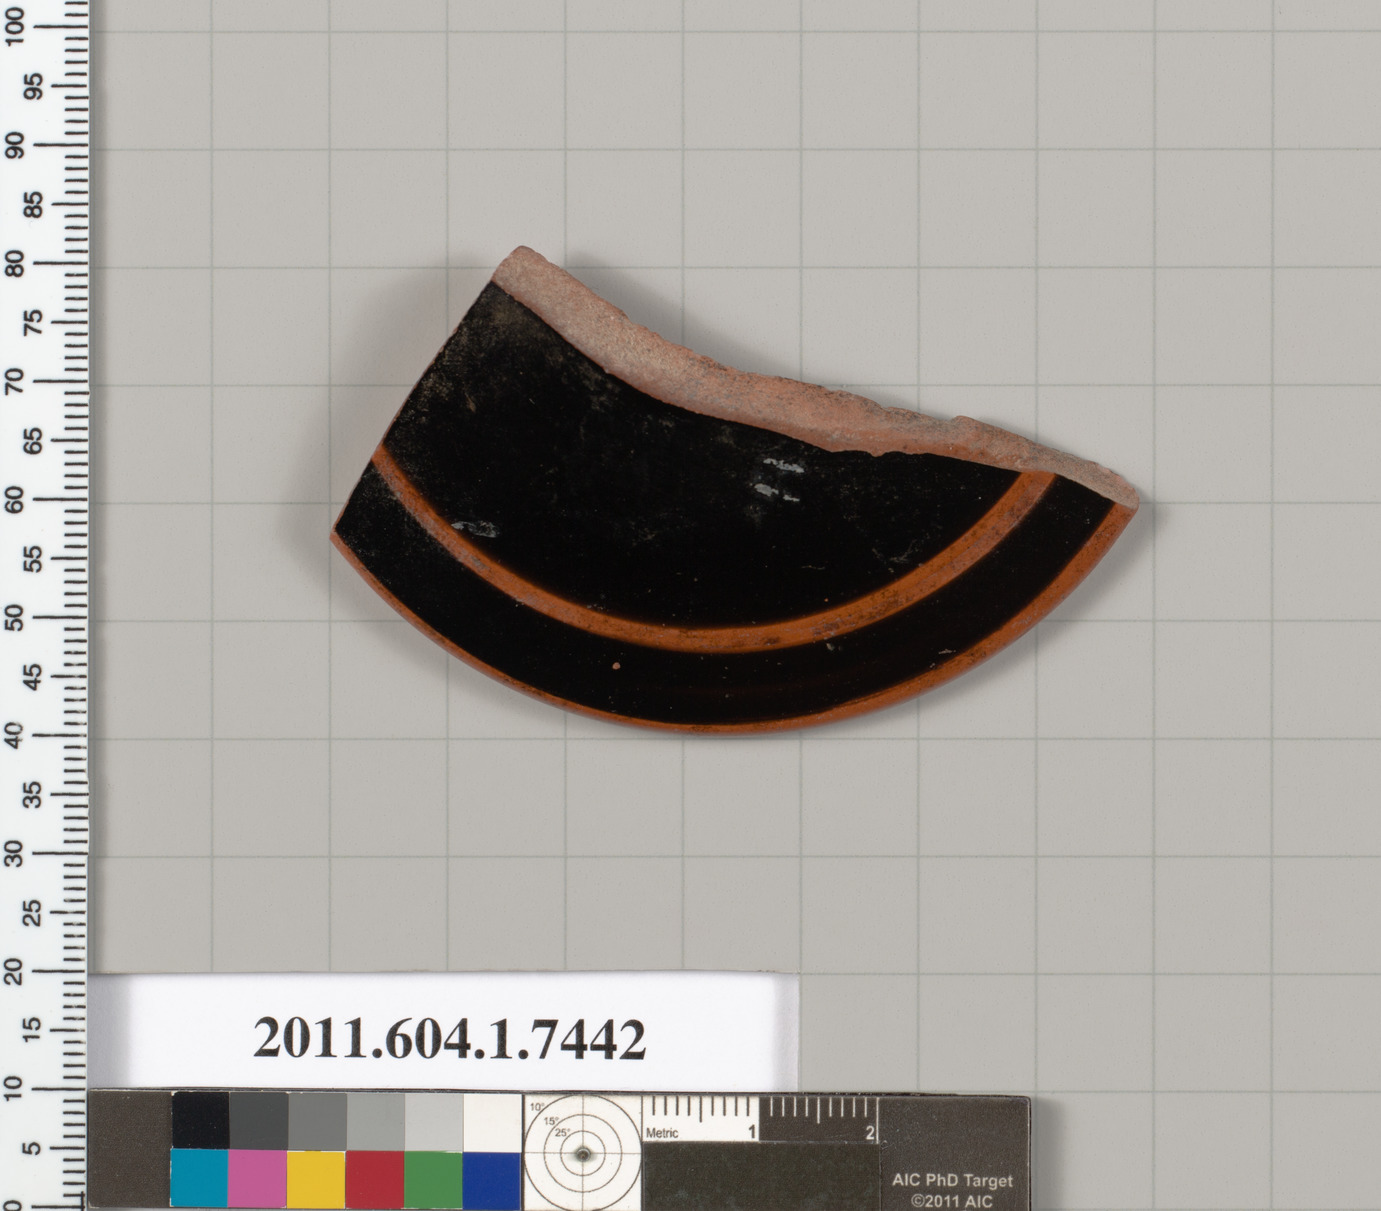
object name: kylix fragment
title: Terracotta fragment of a kylix (drinking cup)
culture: greek, attic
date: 490-470 BCE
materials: terracotta